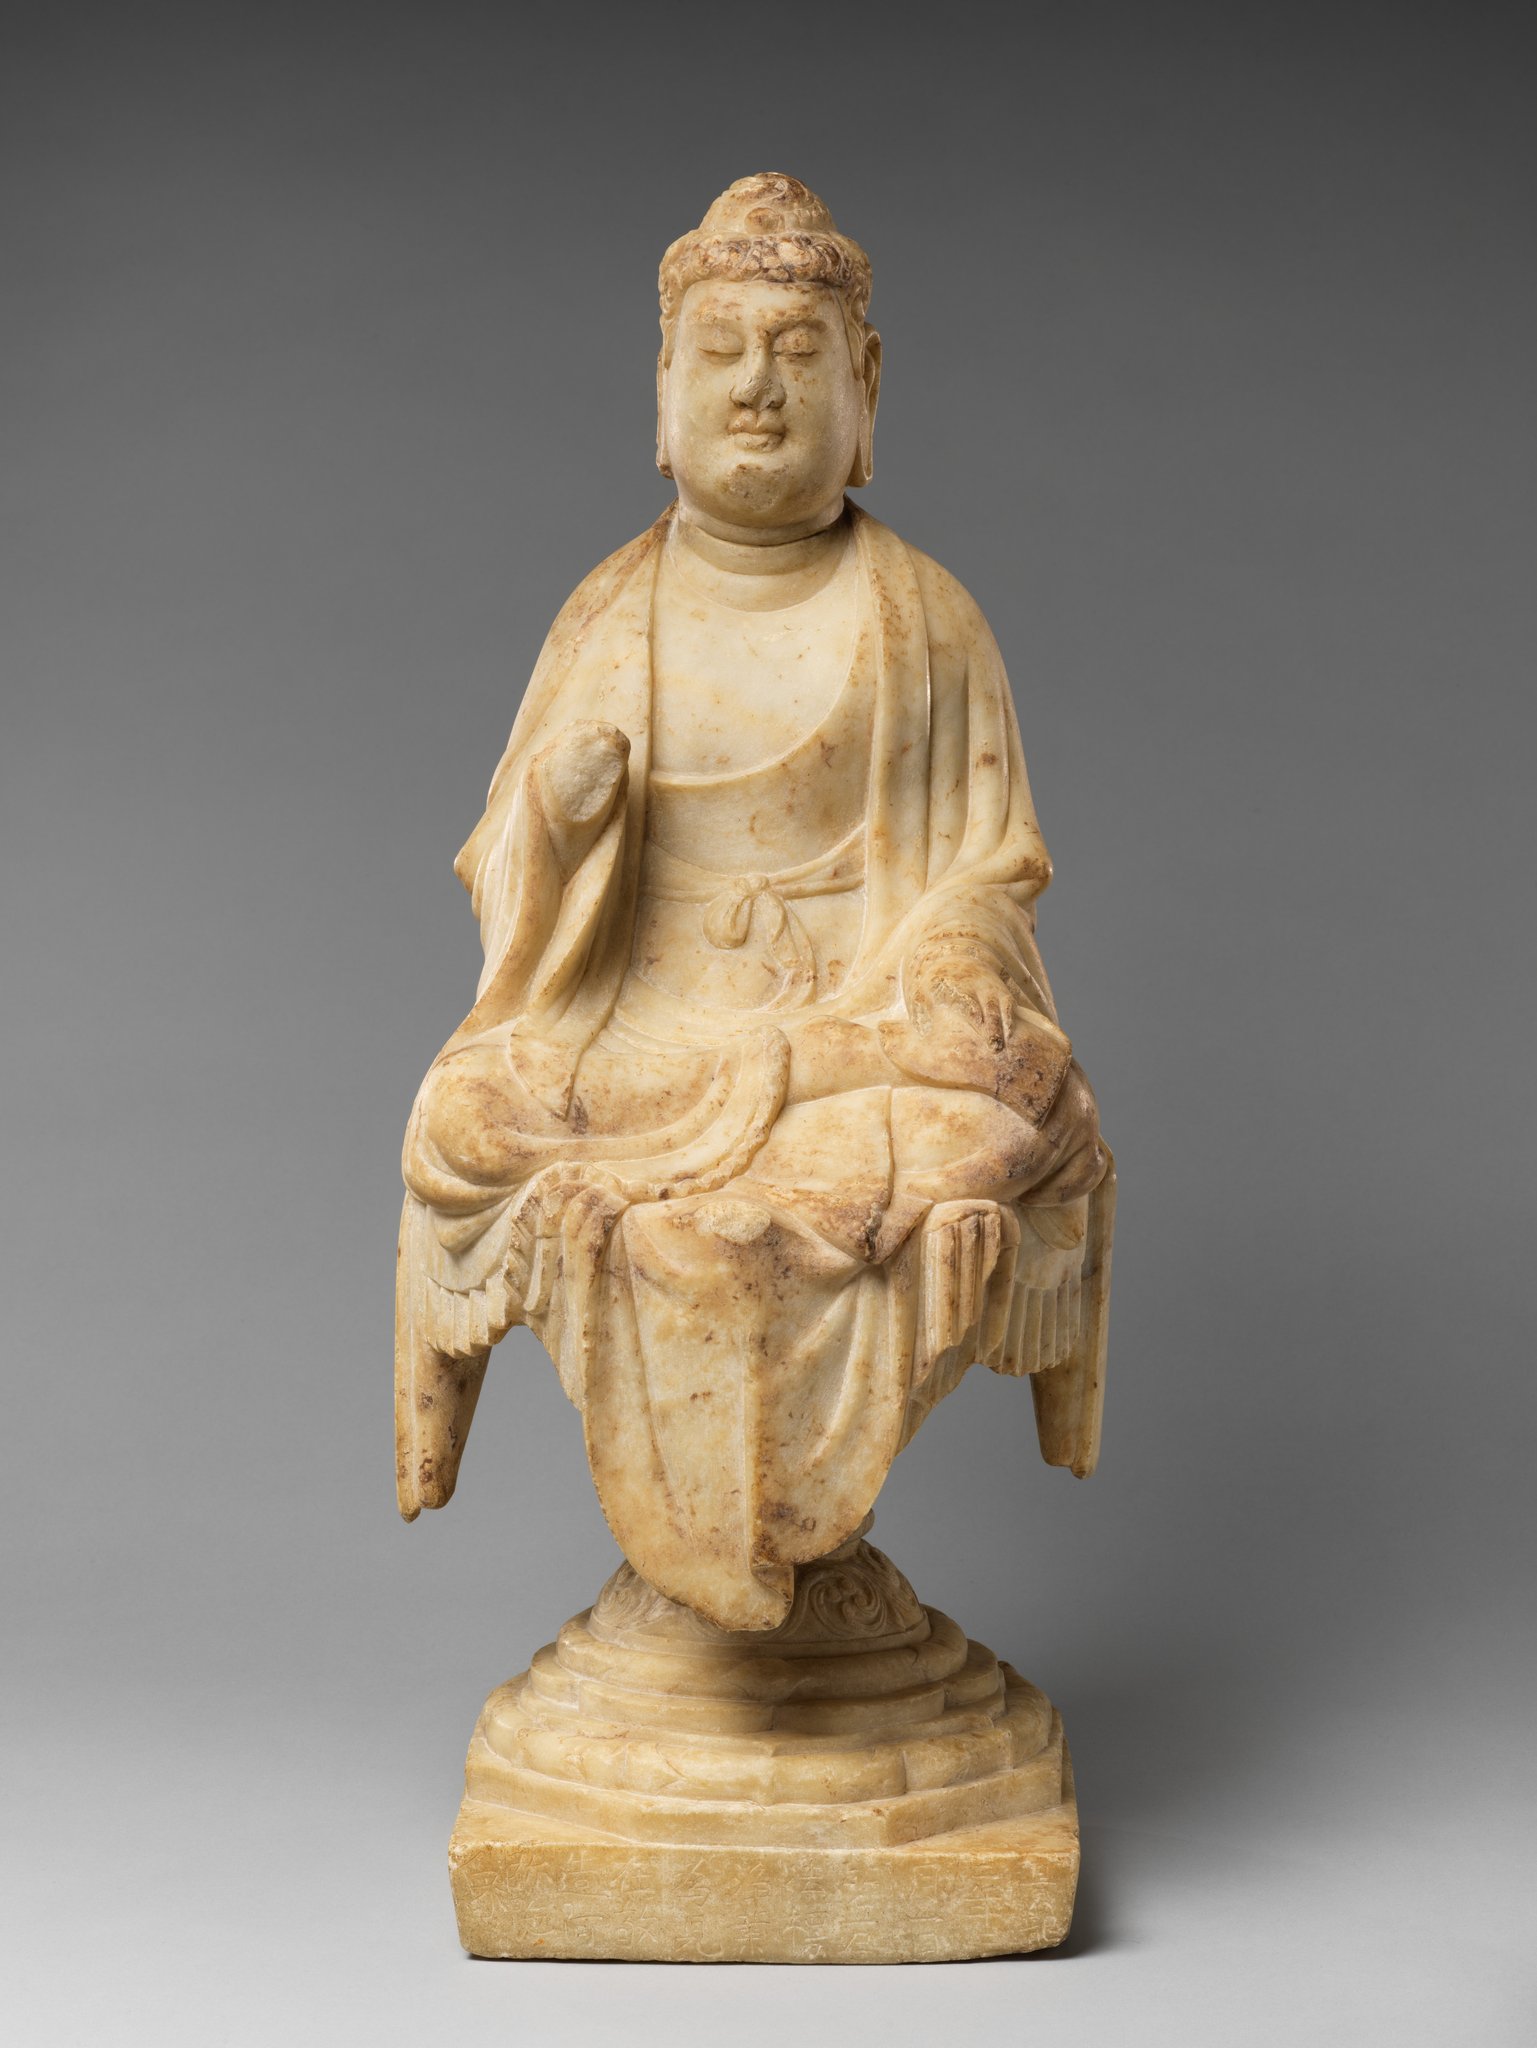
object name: figure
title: Buddha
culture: chinese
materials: marble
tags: buddha